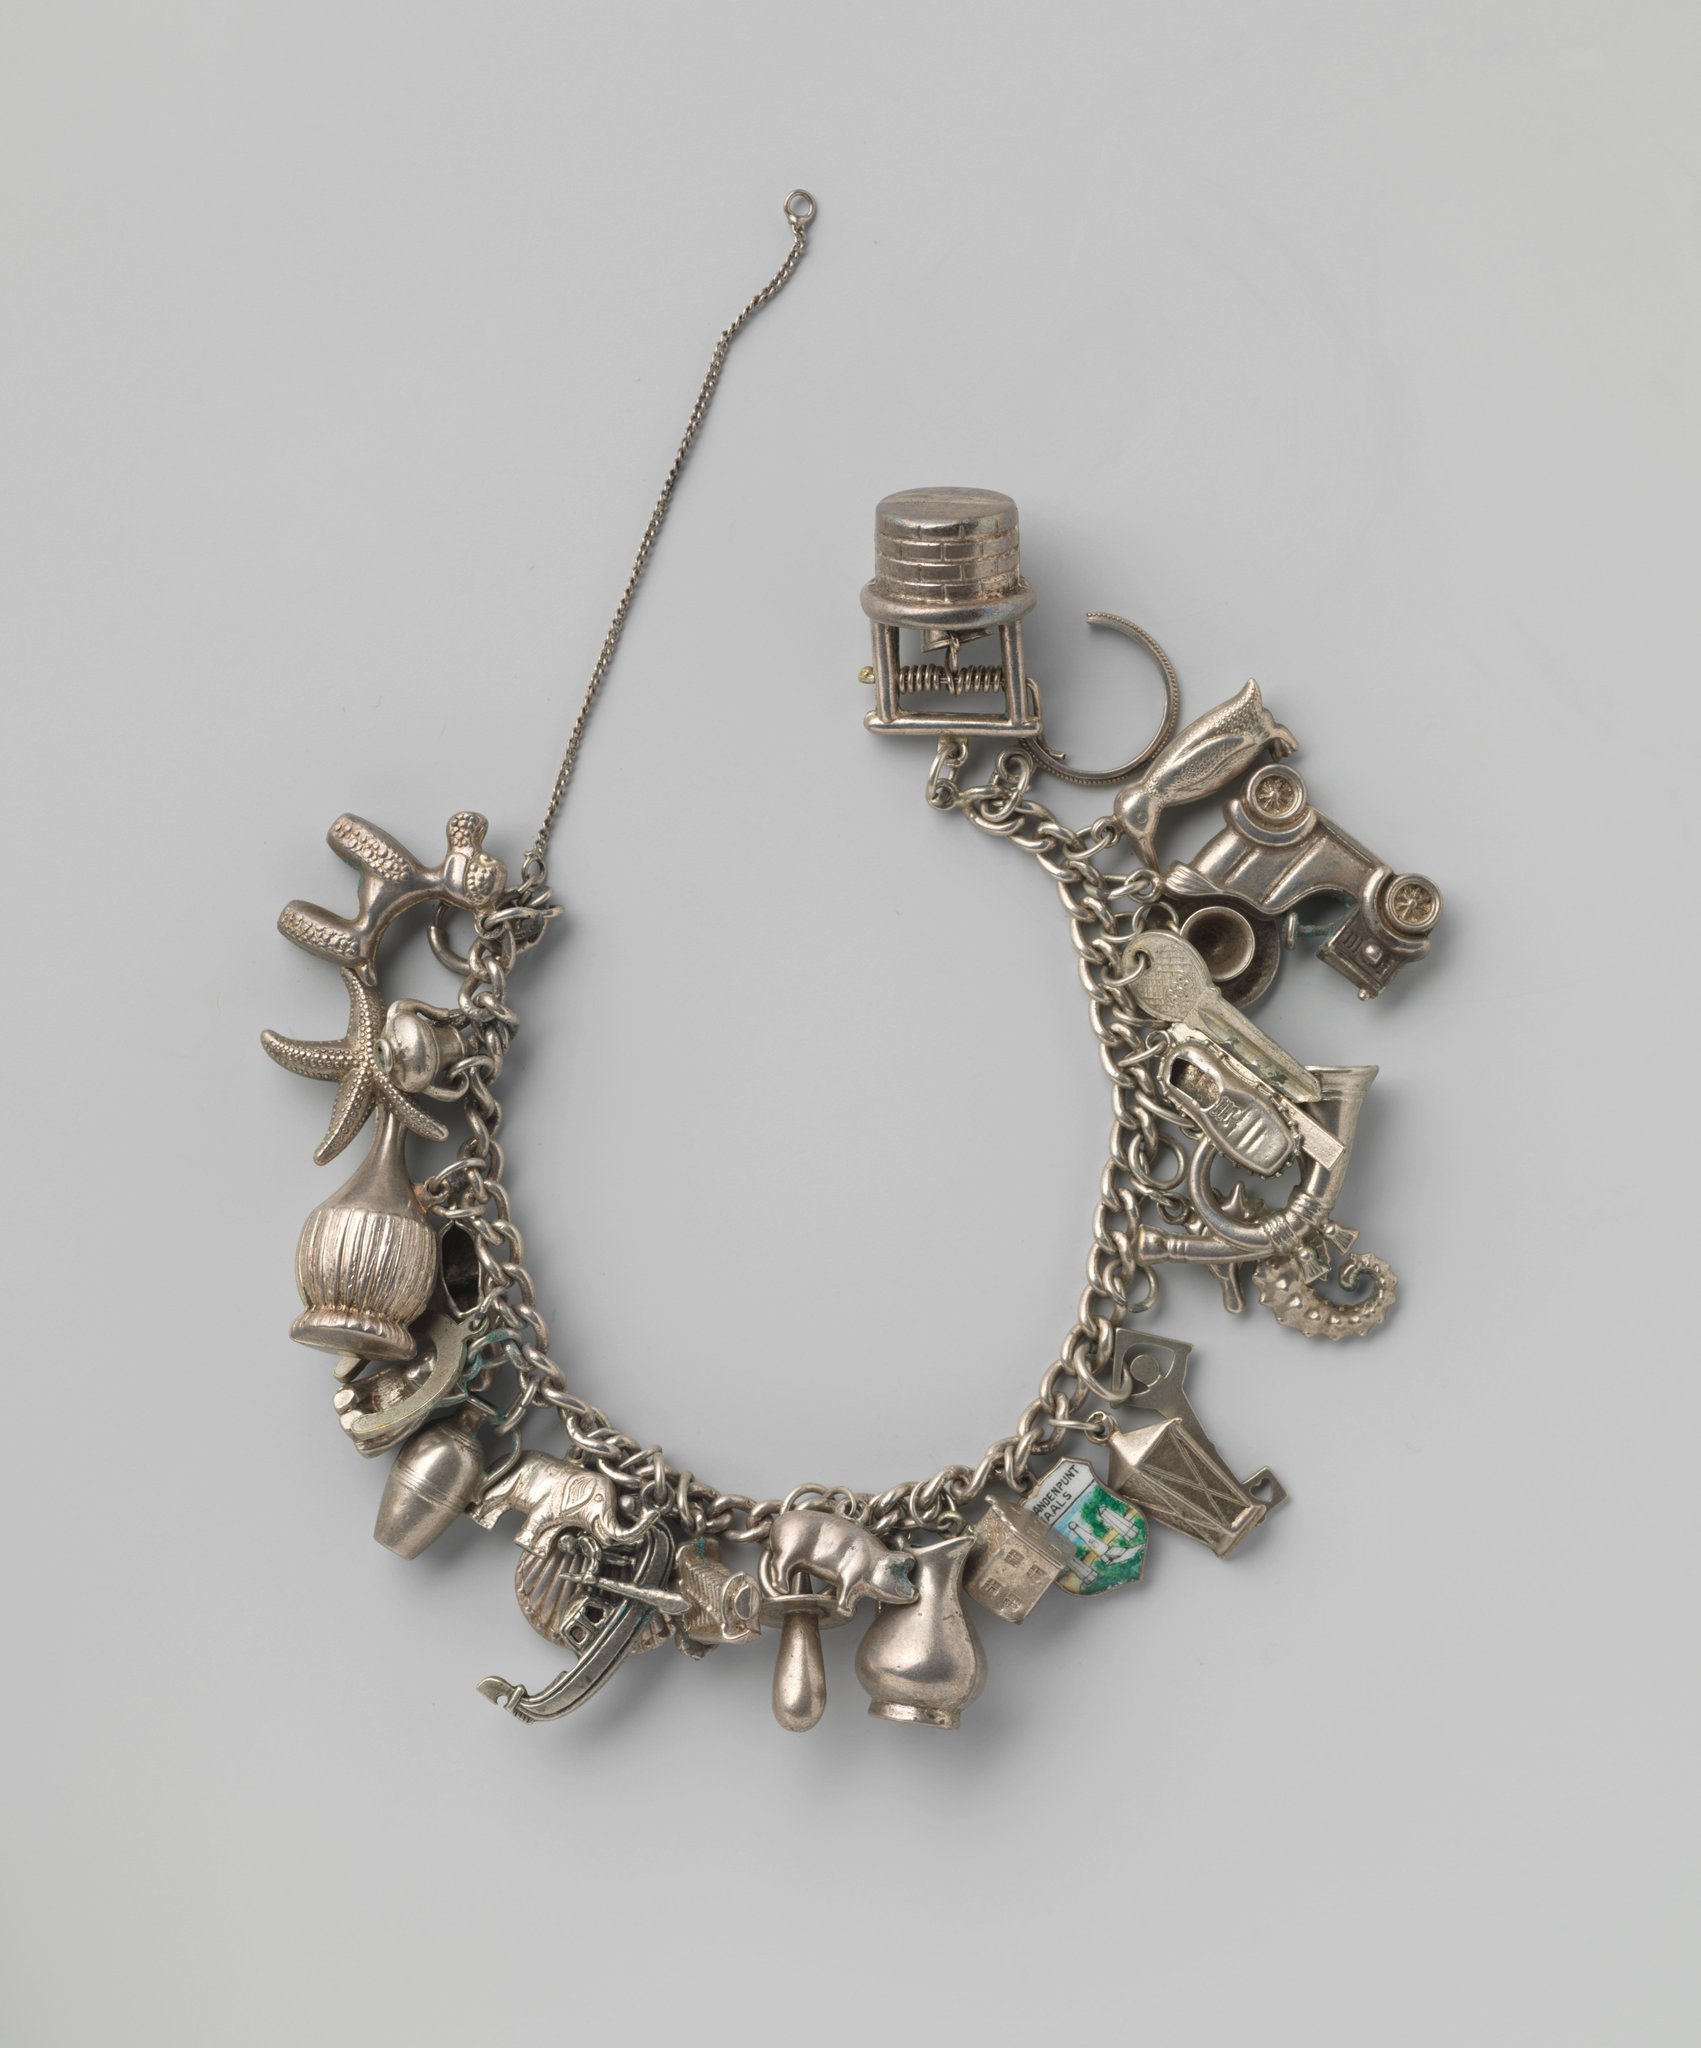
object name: bracelet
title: Bedelarmband met gourmetschakels van zilver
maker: Anonymous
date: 1950-1960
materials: silver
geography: netherlands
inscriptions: : ‘835’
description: Bedelarmband van zilver met achtentwintig bedels, waaronder een waterput, een pinguïn, een auto, een schild, een sleutel, een schoen, een hoorn, een zeepaard, nog een sleutel, een lantaarn, een schild met het Drielandenpunt te Vaals, een huis, een kan, een speen, een varken, een gondel, een camera, een Jacobsschelp, een olifant, een kruik, een zittend dier, een hoefijzer, een mandfles, een thee- of koffiekan, een zeester en een poedel. Één van de sleutels is de sleutel ter gelegenheid van 'Open het dorp' te Arnhem (voor gehandicapten) door Mies Bouwman.